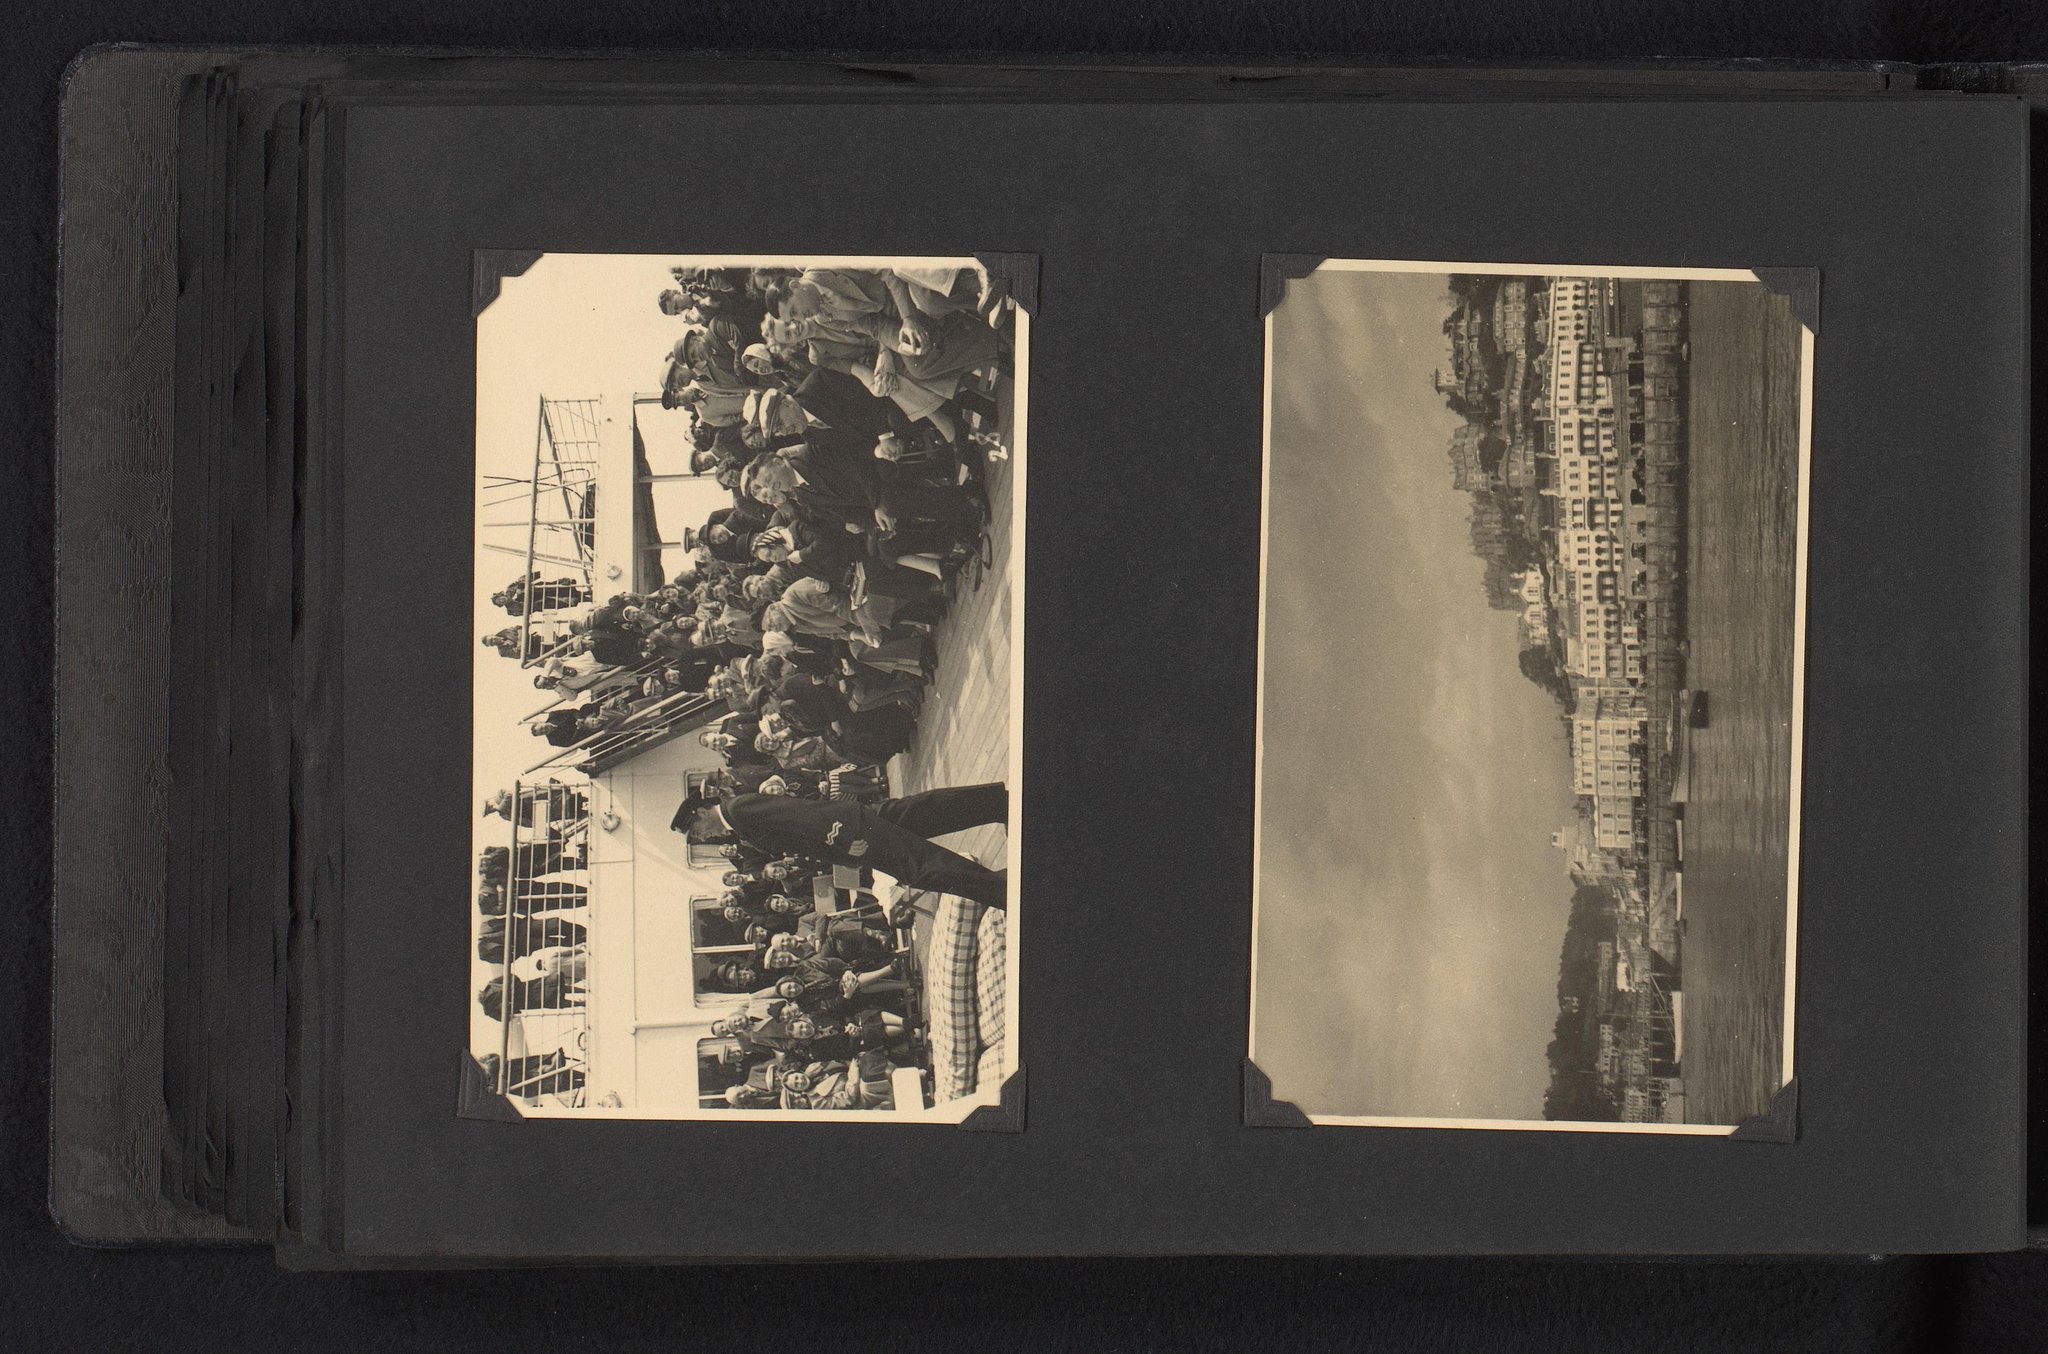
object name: photograph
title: Twee foto's van passagiers aan boord van een schip en de Engelse zuidkust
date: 1934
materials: paper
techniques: gelatin silver print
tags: city-view in general; 'veduta', crew and passengers ~ ship, england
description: Deze foto's maken deel uit van een album.